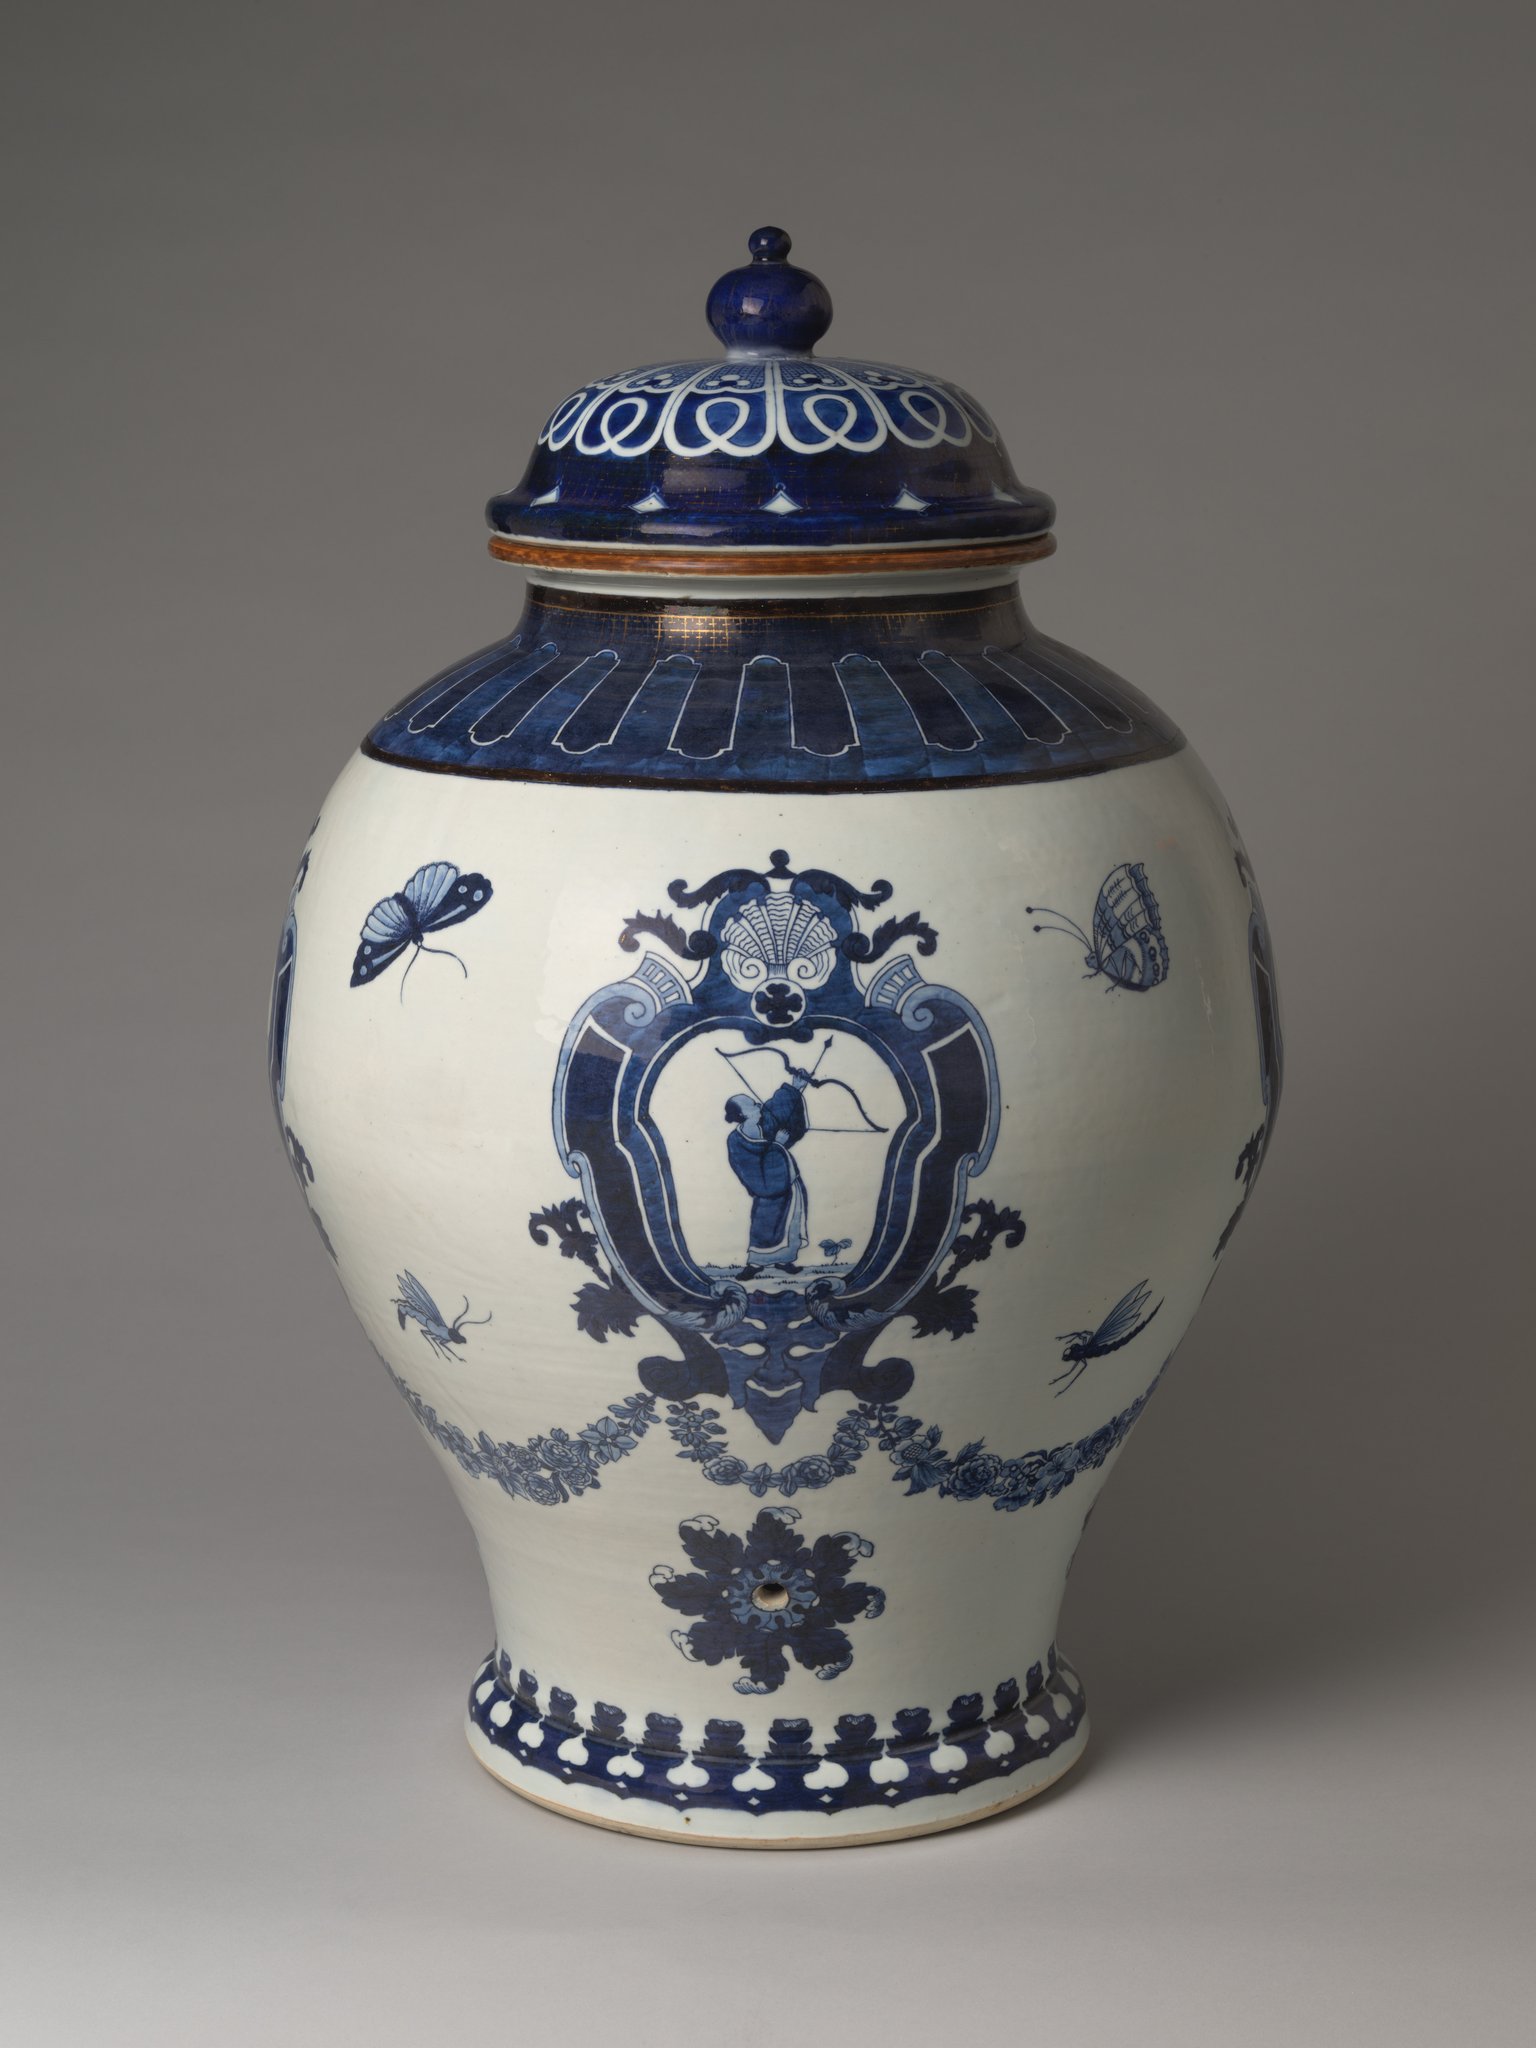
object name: cistern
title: "The Archer" cistern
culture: chinese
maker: cornelis pronk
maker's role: artist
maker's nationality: dutch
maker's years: 1691-1759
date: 1740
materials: cobalt, porcelain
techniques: painting, underglaze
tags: bow and arrow,archery